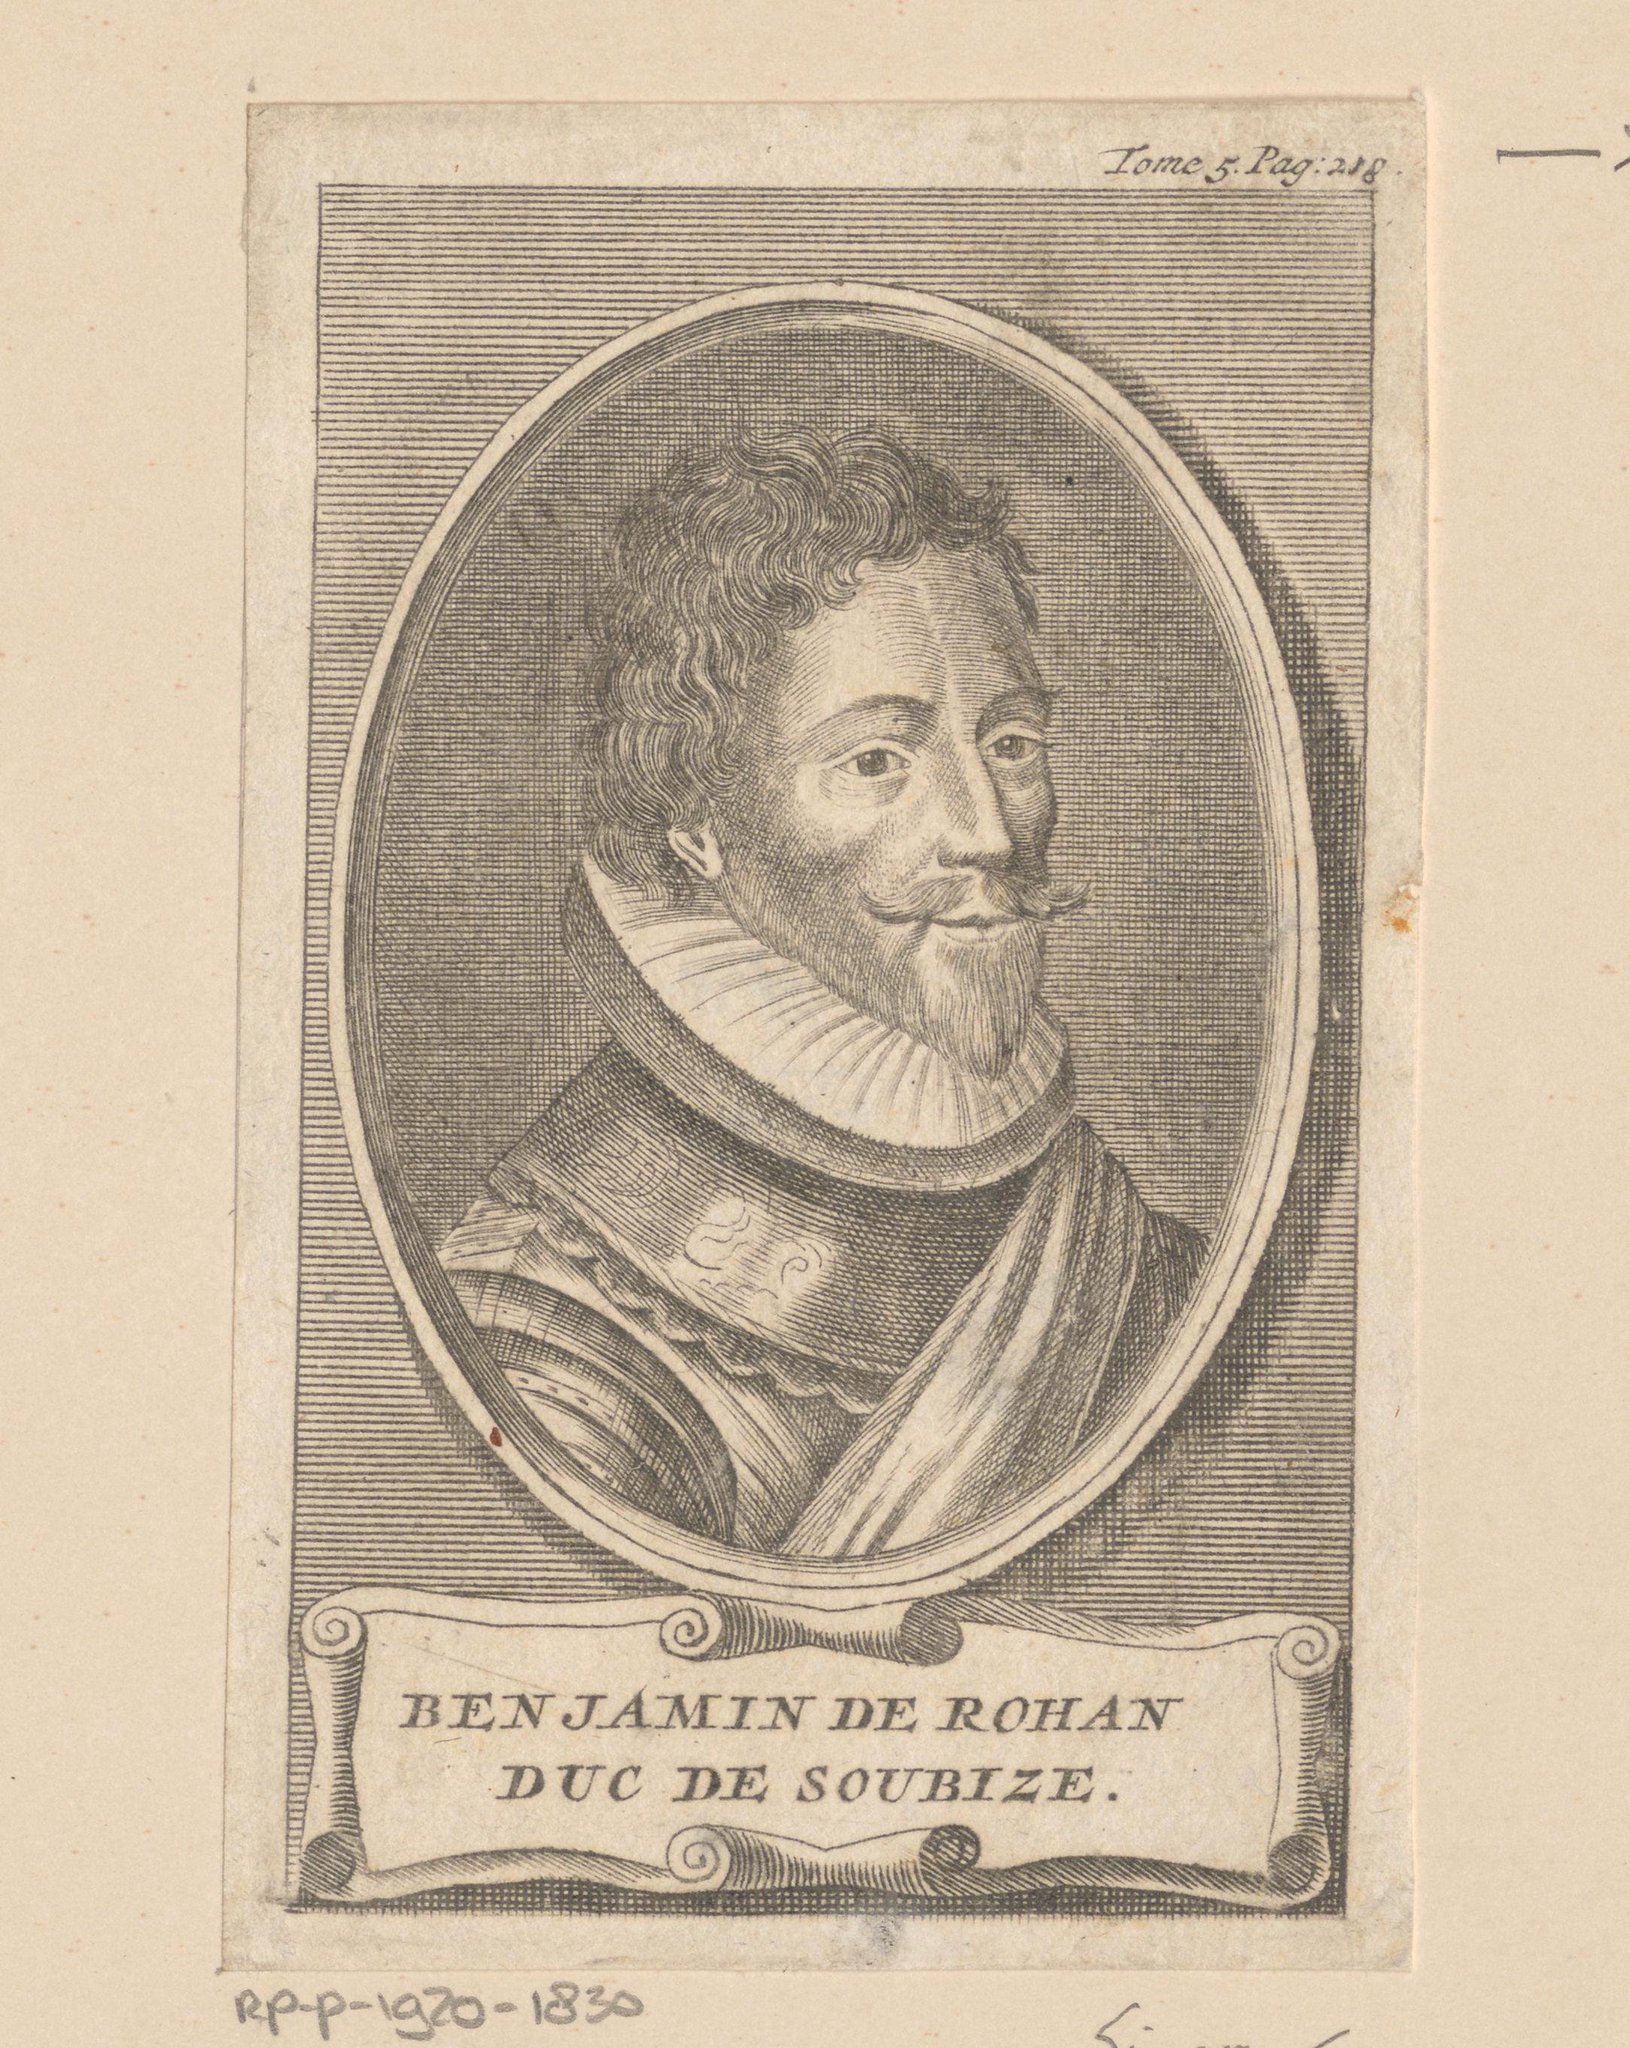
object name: print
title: Portret van Benjamin de Rohan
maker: Anonymous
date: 1717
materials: paper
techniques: engraving, etching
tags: historical persons, commander-in-chief, admiral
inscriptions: collector's mark: Lugt 2228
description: Eerste staat van de prent gebruikt in: Vassor, Michel de. Histoire du regne de Louis XIII, roi de France et de Navarre. Amsterdam: Pierre Brunel, 1717.